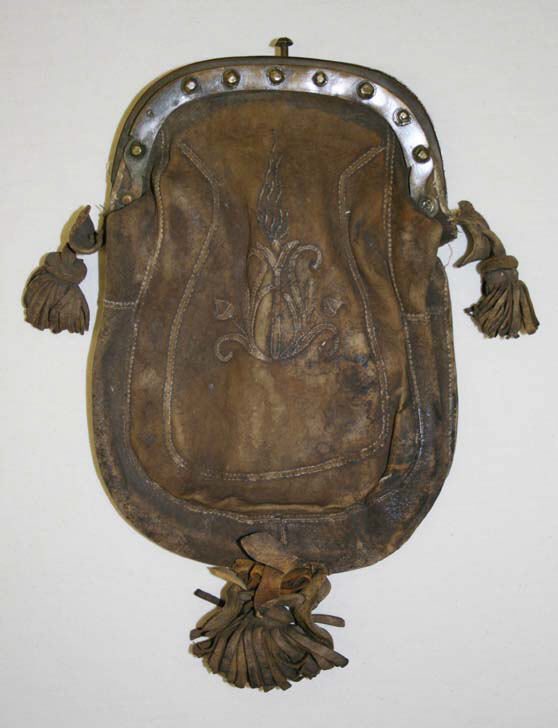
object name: purse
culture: european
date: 1630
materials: leather